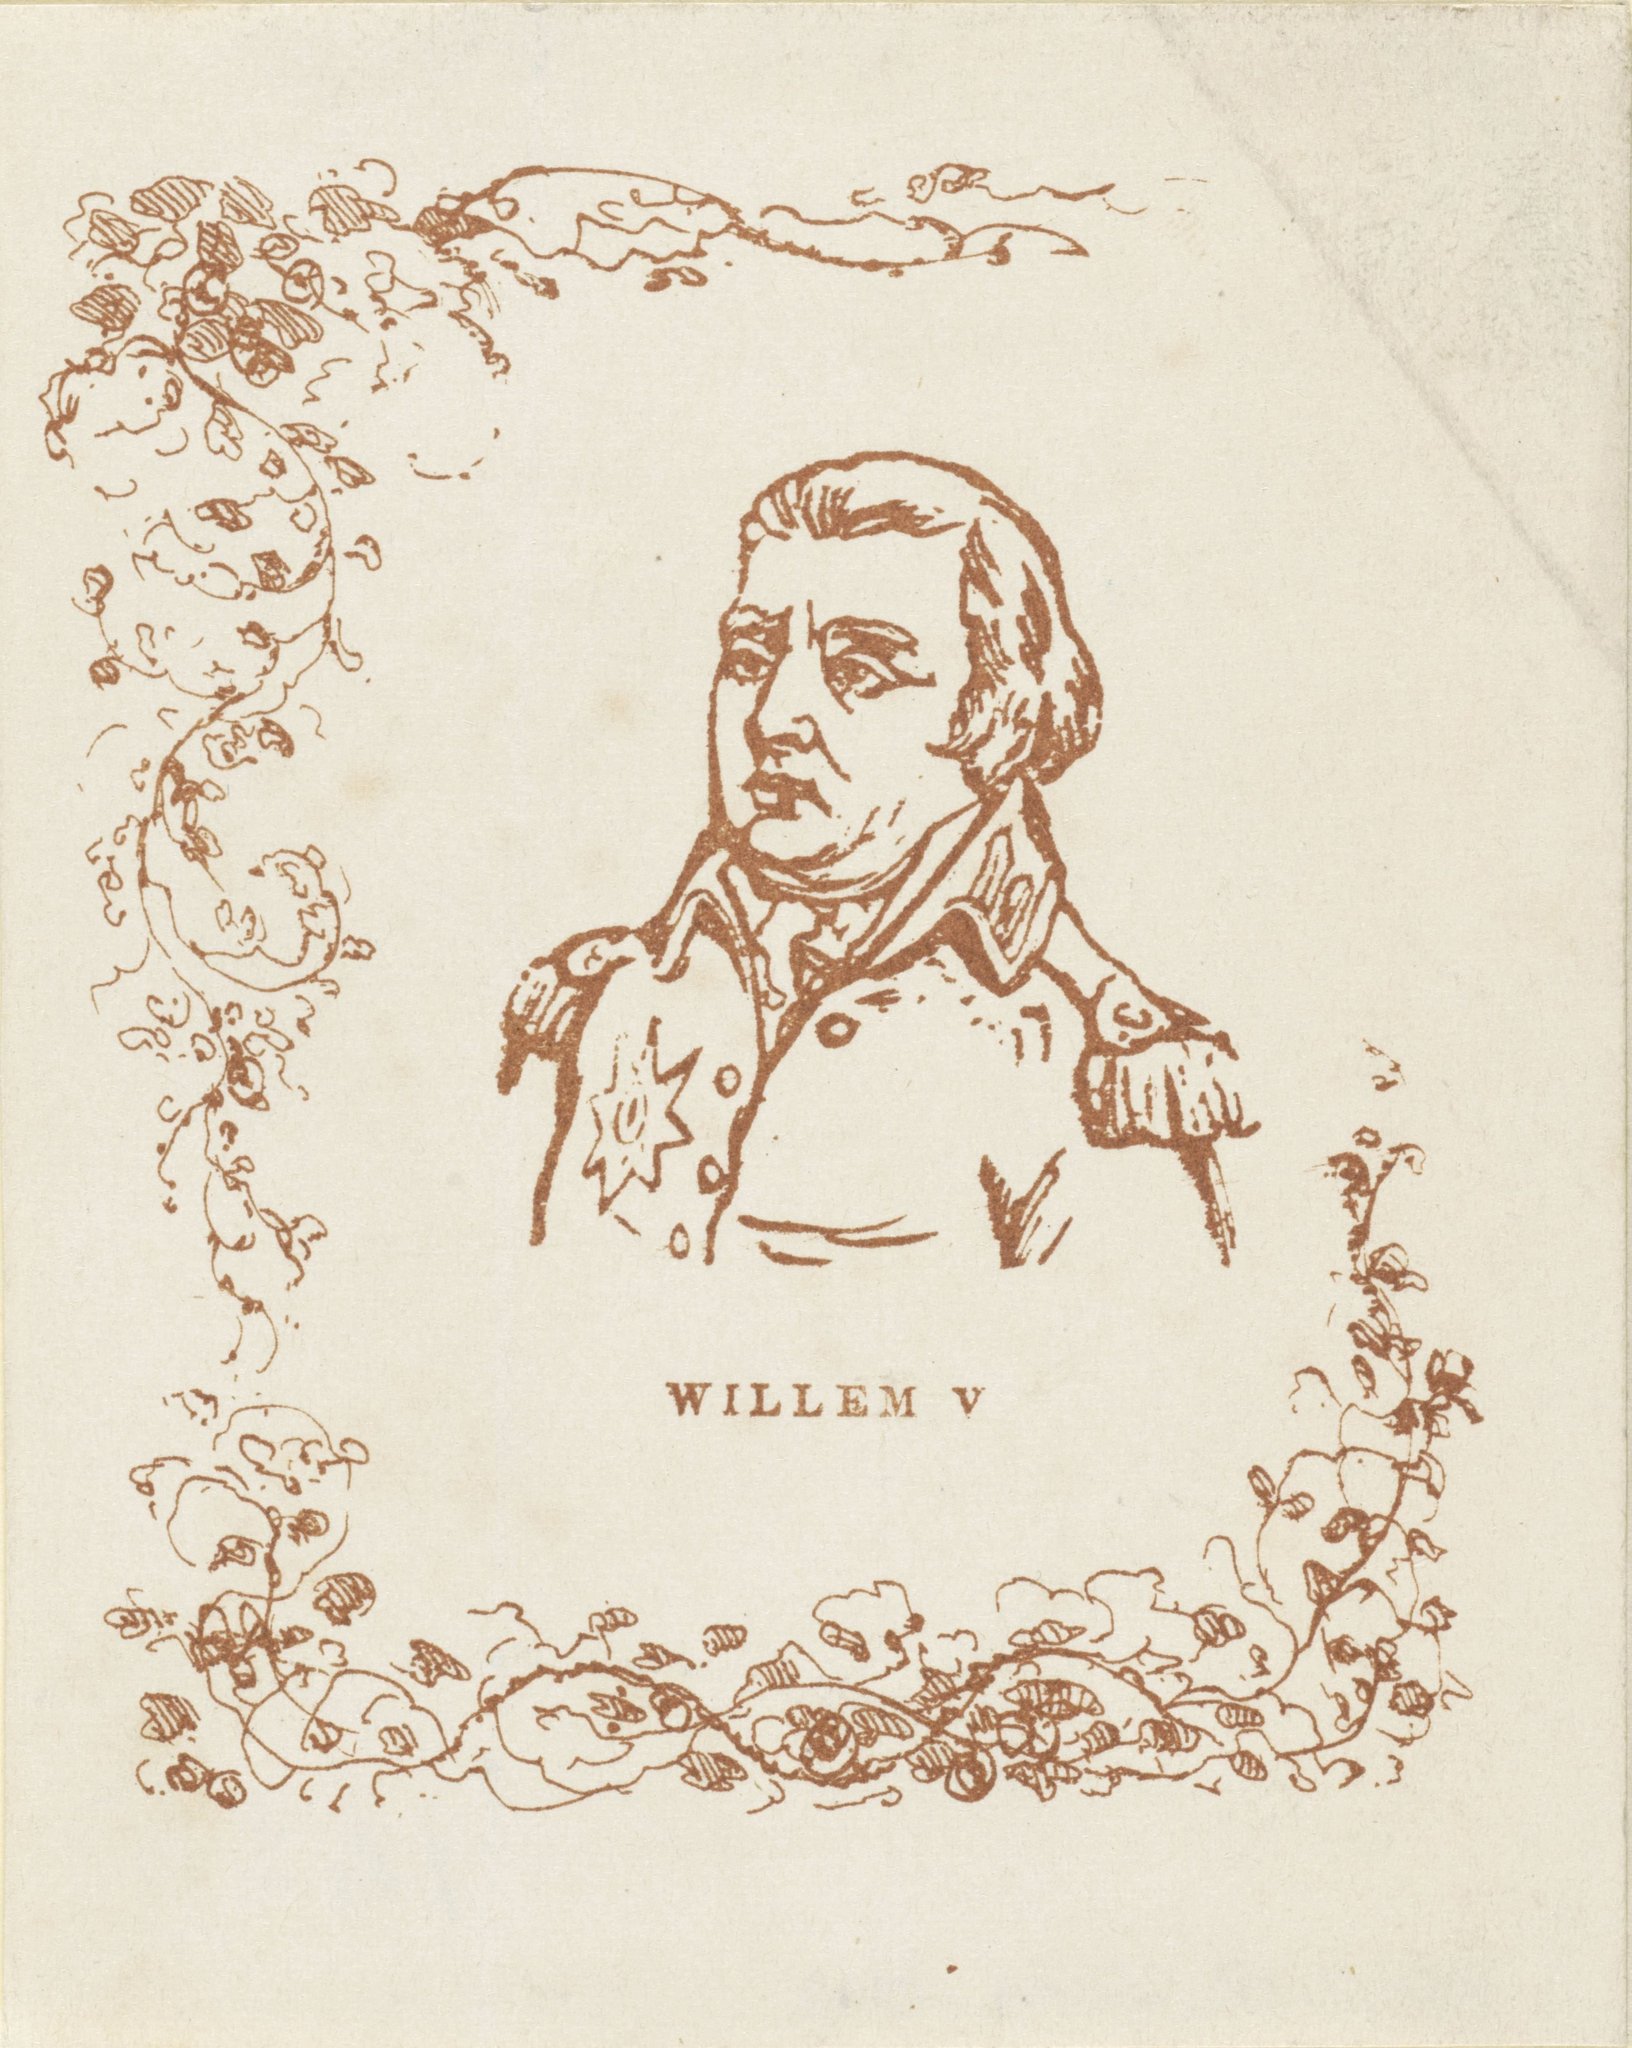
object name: print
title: Portret van Willem V, prins van Oranje-Nassau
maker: Anonymous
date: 1775-1849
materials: paper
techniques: etching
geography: low countries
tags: the hague, william v (prince of orange)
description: De hier vermelde titel verwijst naar de hoogst verkregen titel van de geportretteerde, niet per se naar de titel die de geportretteerde op deze voorstelling draagt.